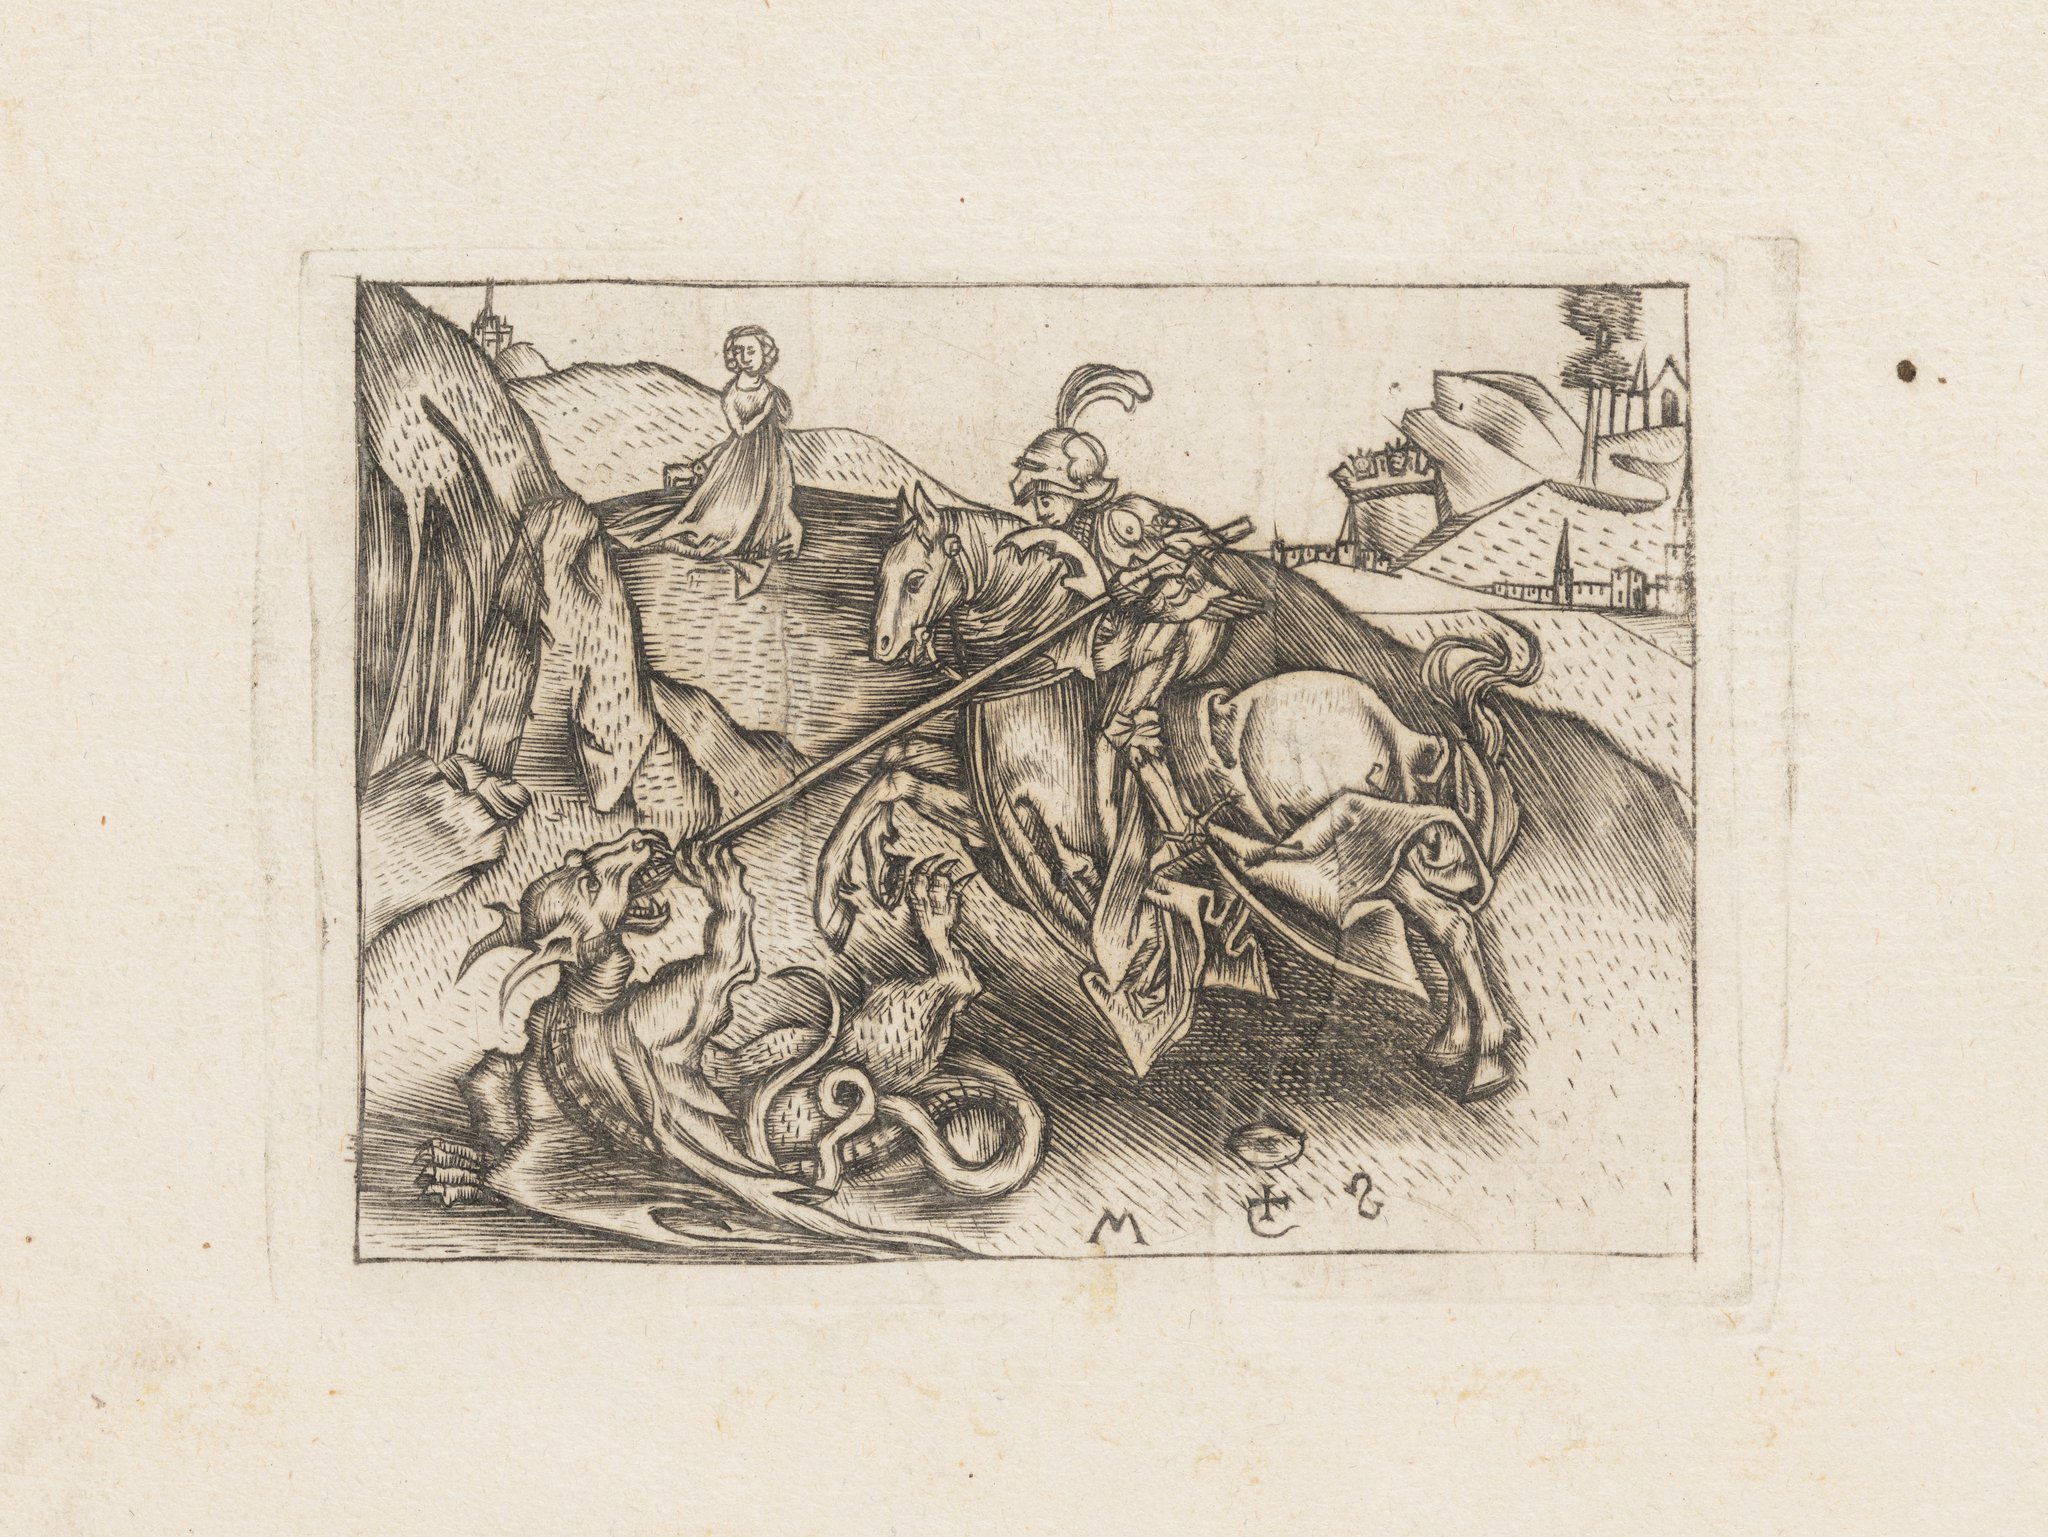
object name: print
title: St. George and the Dragon; Designs for Goldsmiths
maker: israhel van meckenem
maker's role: artist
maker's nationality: german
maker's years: 1435-1503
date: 1470-1503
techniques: engraving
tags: spears,women,horses,saint george